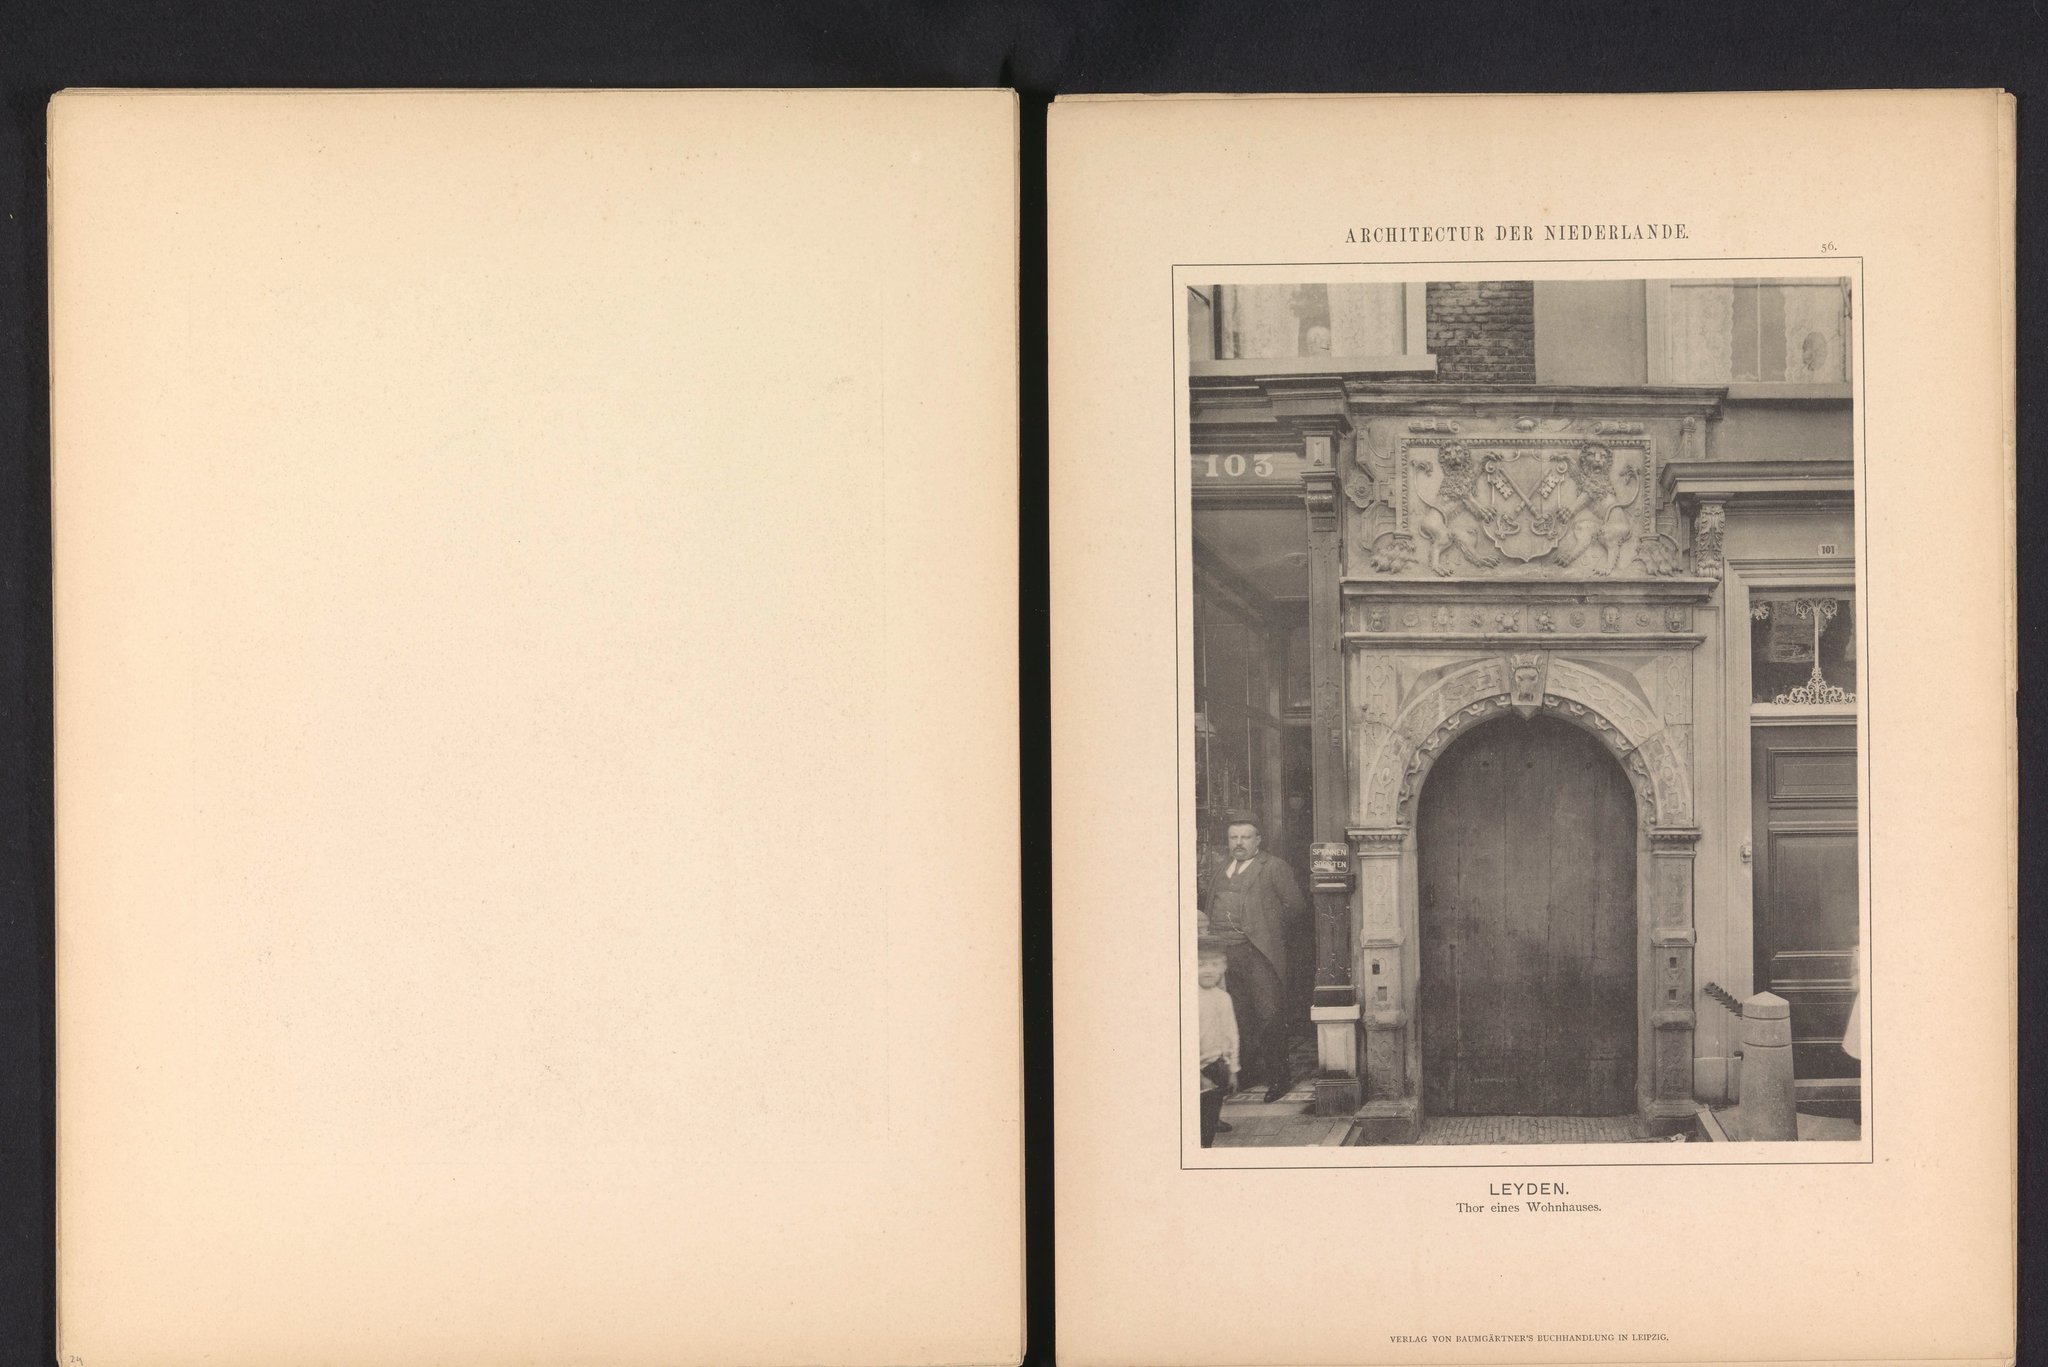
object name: photomechanical print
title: Leyden. Thor eines Wohnhauses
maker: Anonymous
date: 1884-1894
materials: paper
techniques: photograph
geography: leiden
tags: stone tablet in façade, gate, entrance, leiden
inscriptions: number: ‘56.’